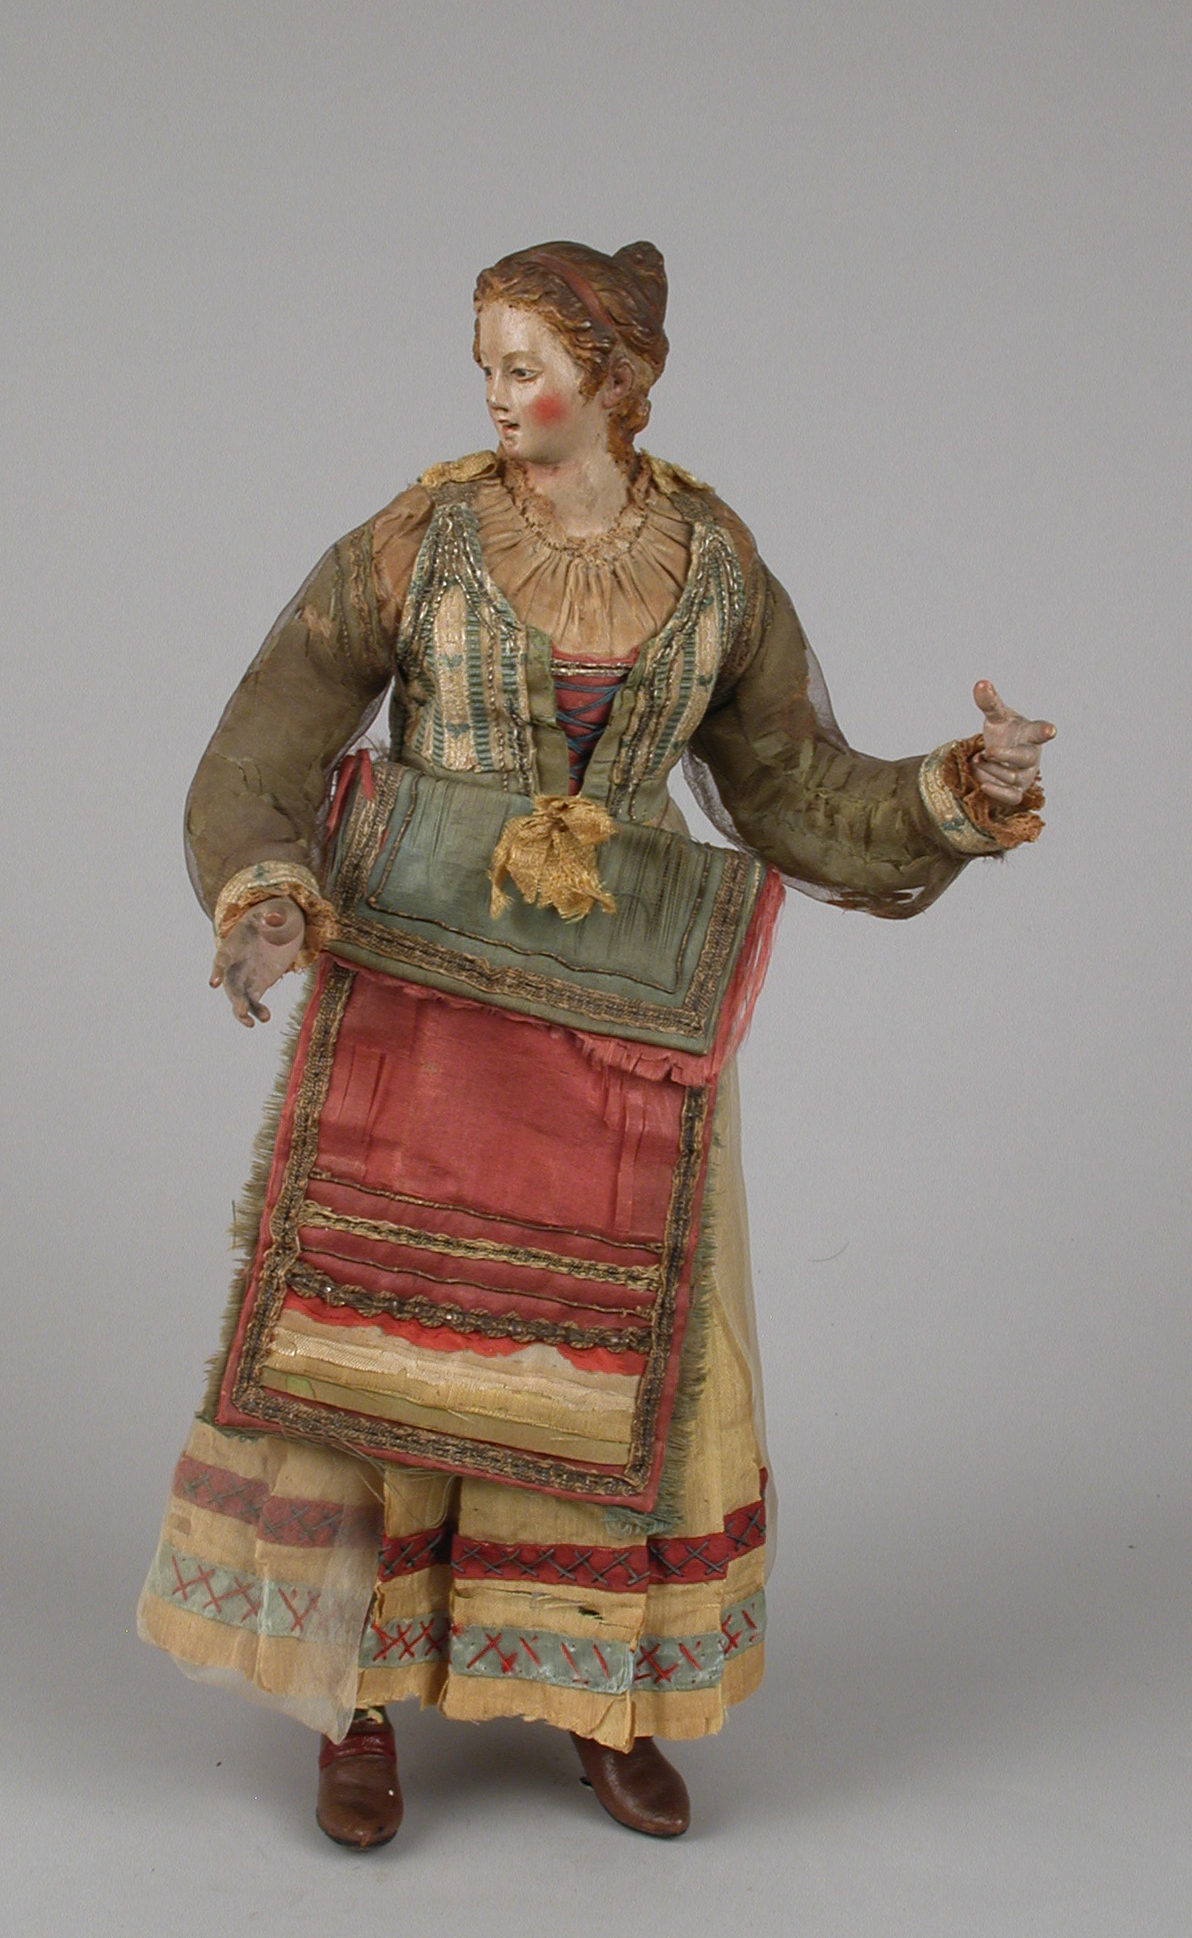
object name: crèche figure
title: Standing woman in festival dress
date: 1767-1833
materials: linen, silk, terracotta, fiber, metal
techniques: polychrome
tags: women